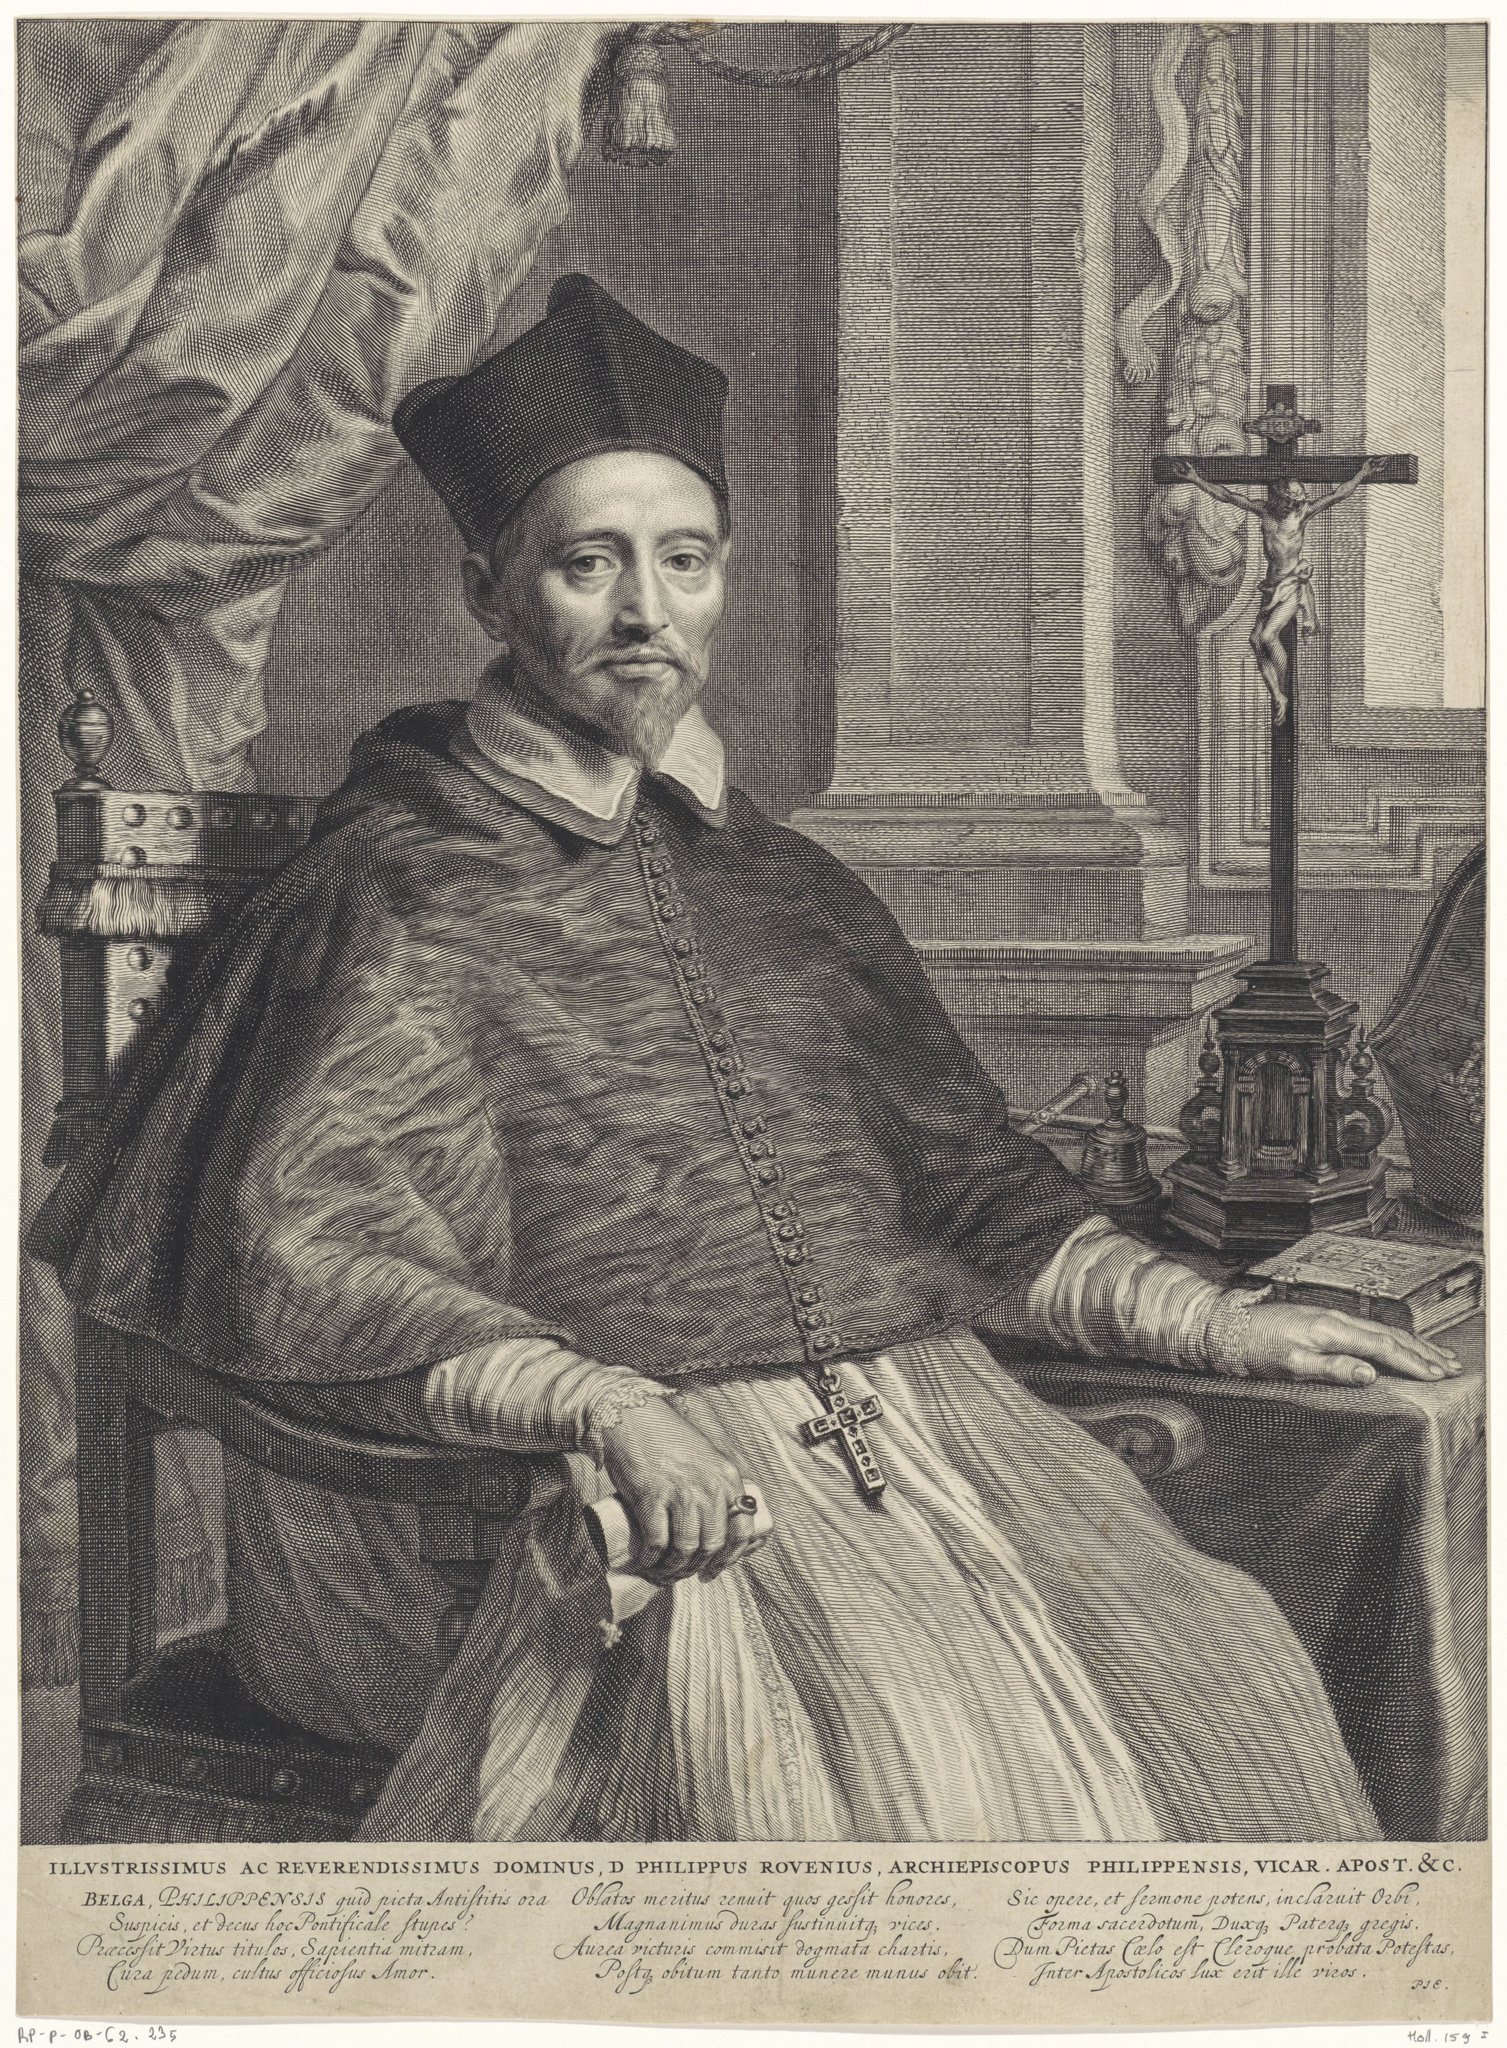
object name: print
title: Portret van Filips van Rouveen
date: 1651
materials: paper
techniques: engraving, etching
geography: haarlem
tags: bible, crucifix ~ personal devotion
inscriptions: collector's mark: Lugt 240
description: Portret van apostolisch vicaris Filips van Rouveen (Philippus Rovenius) zittend op een stoel met naast zich op tafel een bijbel en een crucifix.